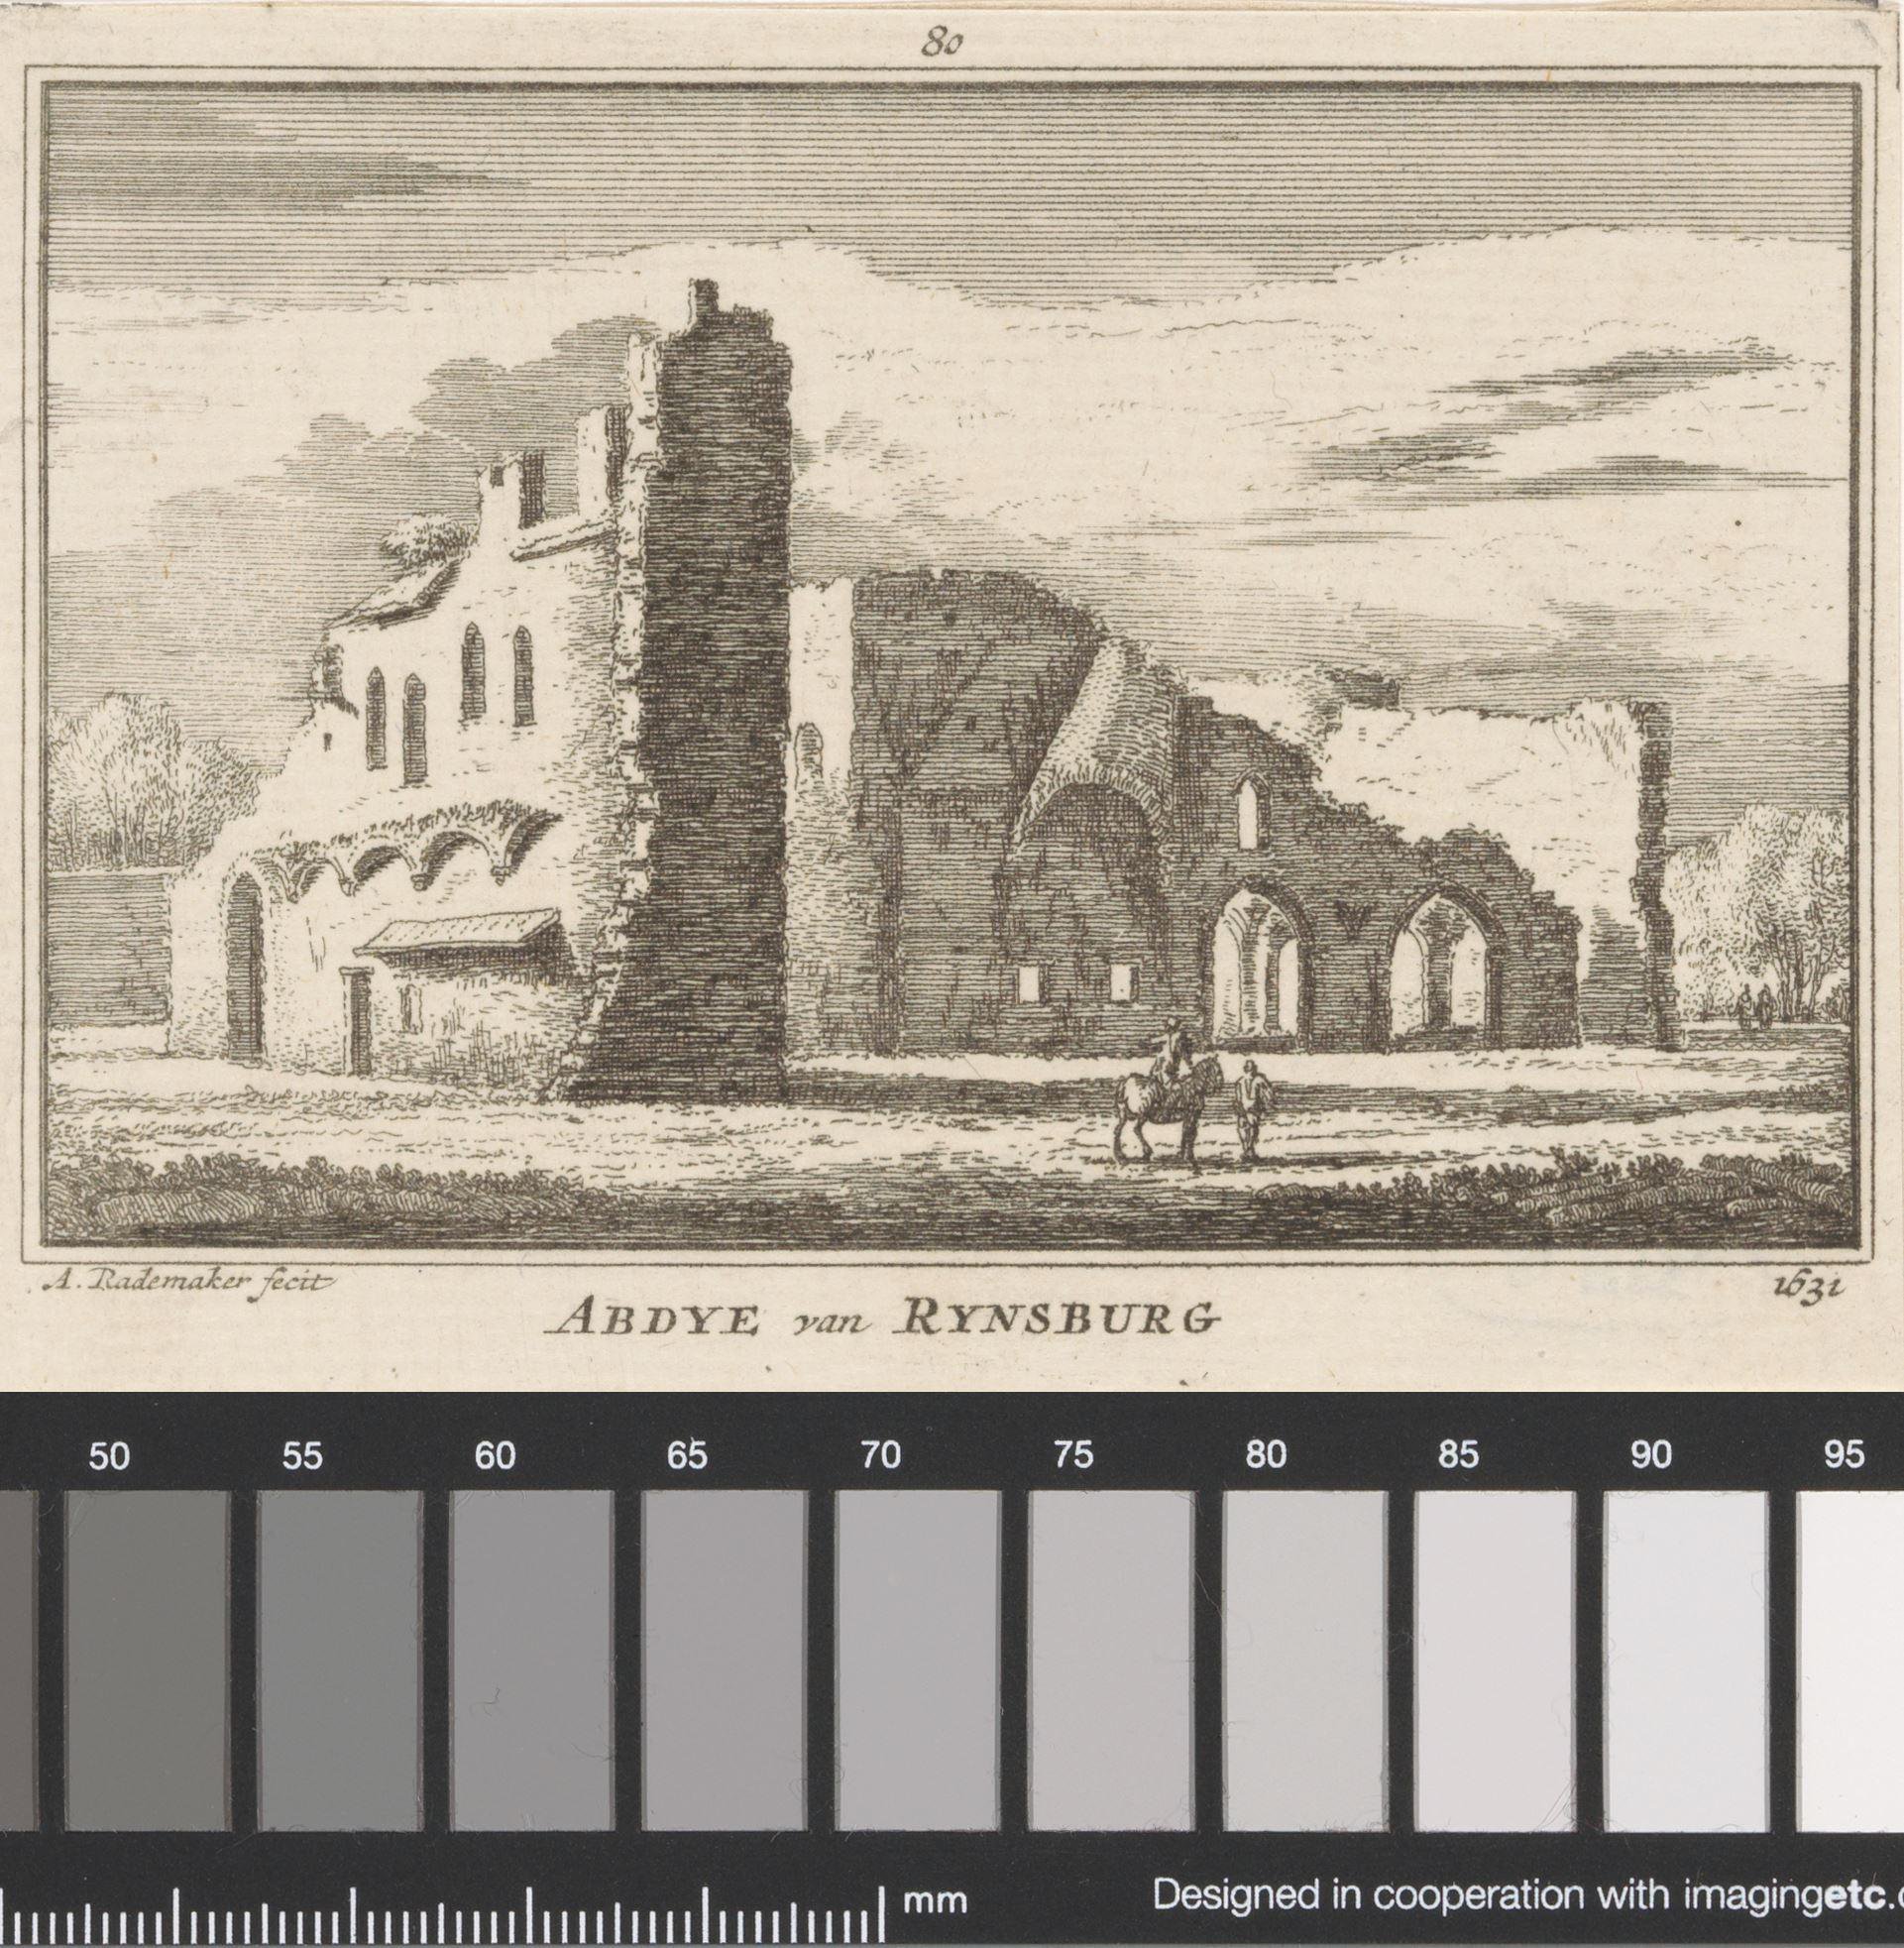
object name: print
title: Gezicht op de ruïne van de abdij te Rijnsburg, 1631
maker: abraham rademaker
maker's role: draughtsman, print maker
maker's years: 1676-1735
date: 1725-1803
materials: paper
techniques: engraving, etching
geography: amsterdam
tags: ruin of church, monastery, etc.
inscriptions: collector's mark: Lugt 2228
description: Prent ook gebruikt in: Rademaker, Abraham. Kabinet van Nederlandsche outheden en gezichten: vervat in 300 konstplaaten (…). 2 delen. Amsterdam: Willem Barents, 1725, dl. 1, ill. 80. Na 1725 is deze prent nog in verschillende heruitgaven verschenen, uitgegeven in 1727-1733, 1770-1771 en 1792-1803. Uit welke uitgave het huidige exemplaar precies komt is niet na te gaan.